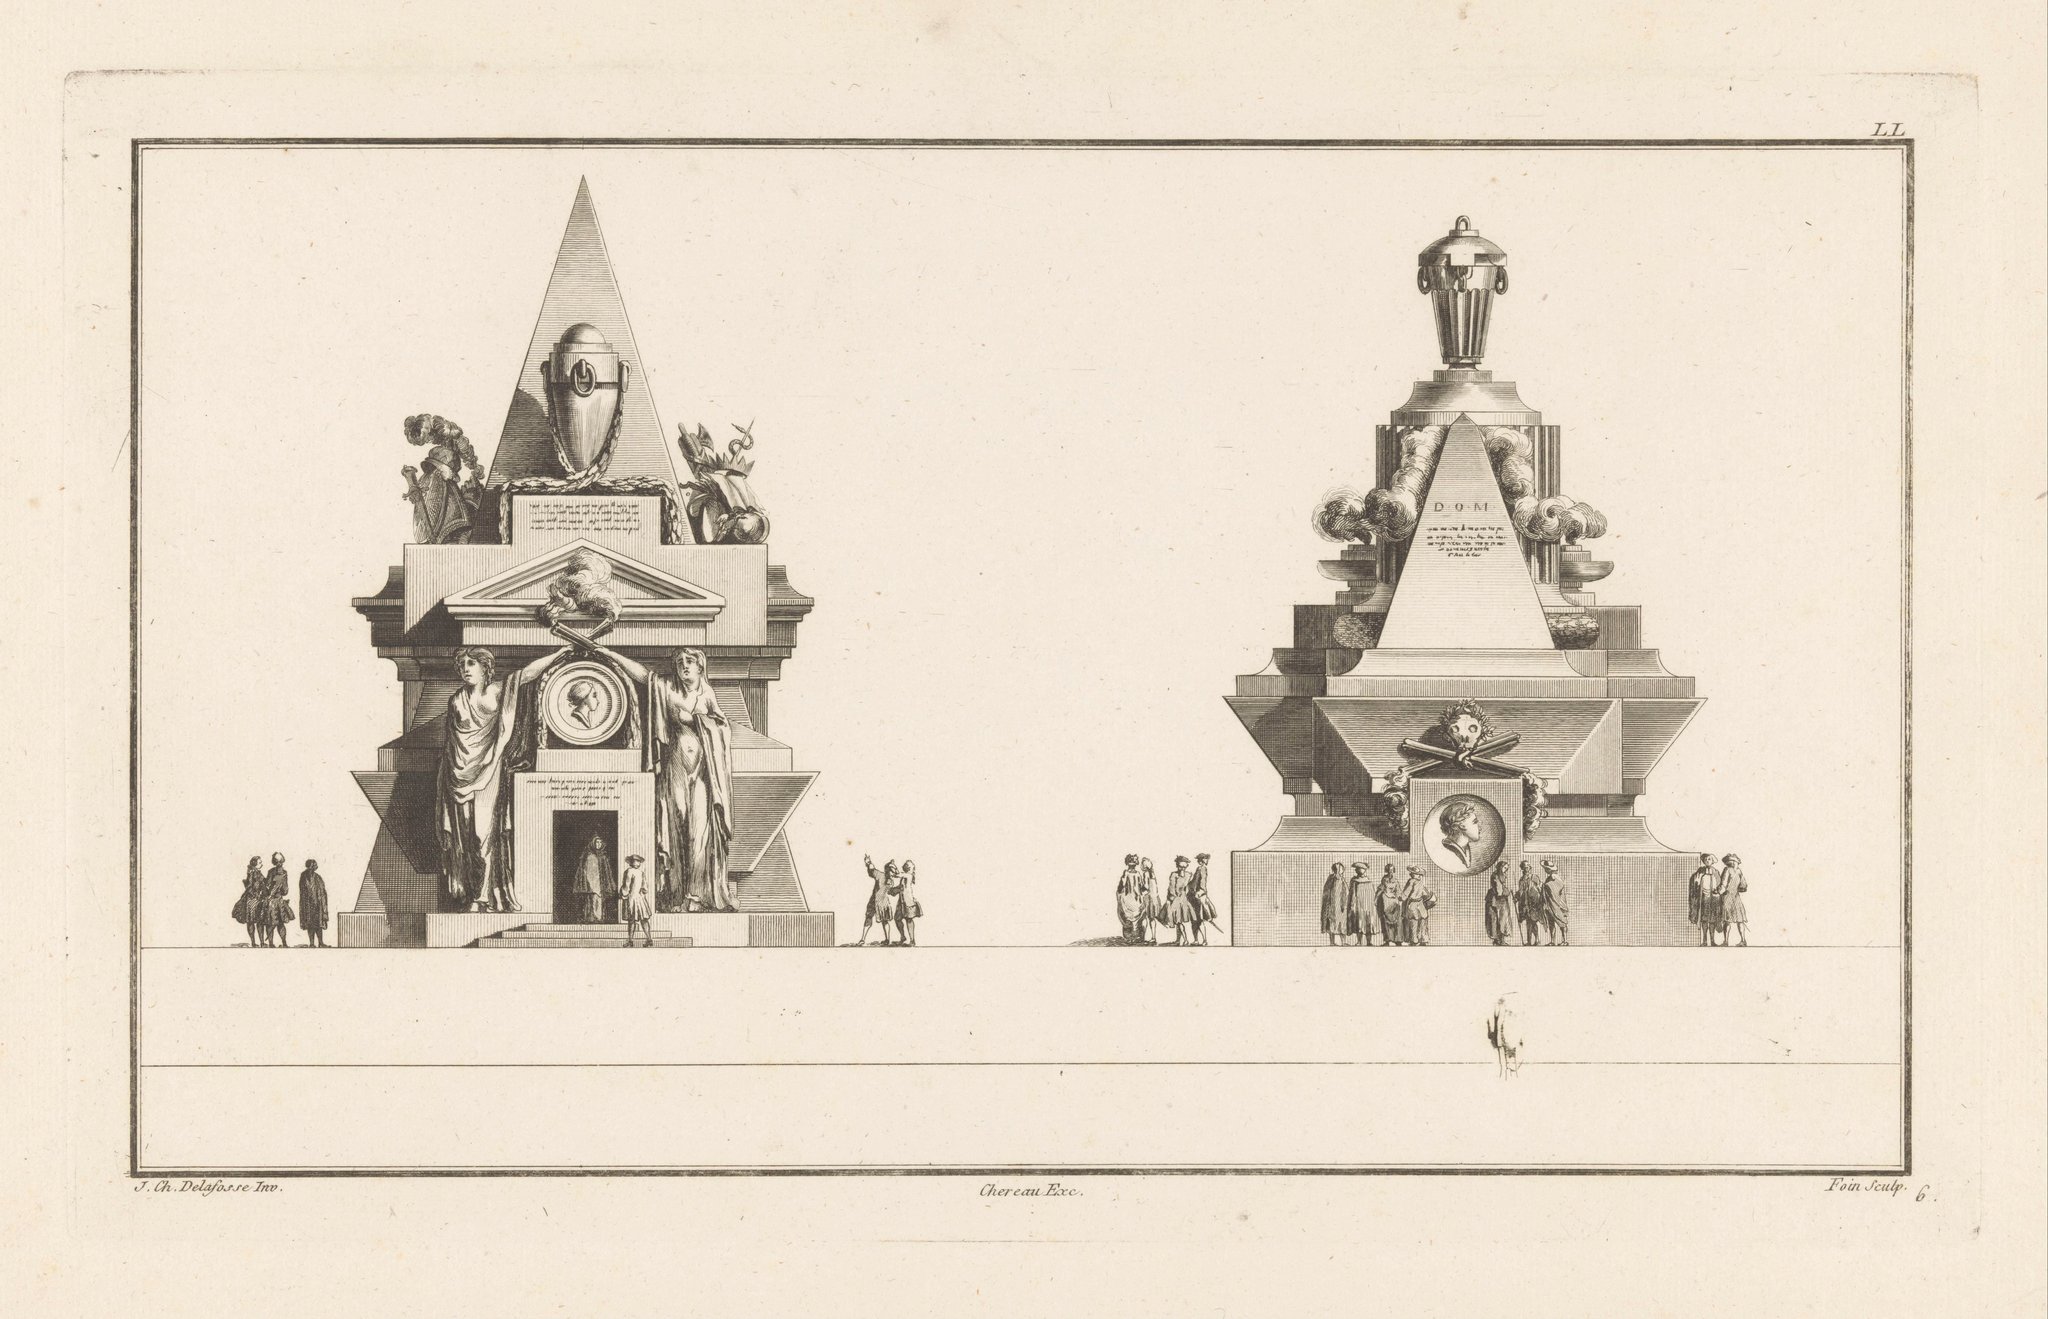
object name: print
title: Twee tombes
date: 1771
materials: paper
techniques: engraving, etching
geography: paris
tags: grave, tomb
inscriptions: collector's mark: Lugt 2228, collector's mark: Lugt 2760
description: Links een tombe met een ingang, twee vrouwen met fakkels aan weerszijden van een rond medaillon met portret en profil, wapens met helm en kroon en een urn. Rechts een tombe met een rond medaillon met portret en profil, een gelauwerde schedel met fakkels, rookvaten en een urn.